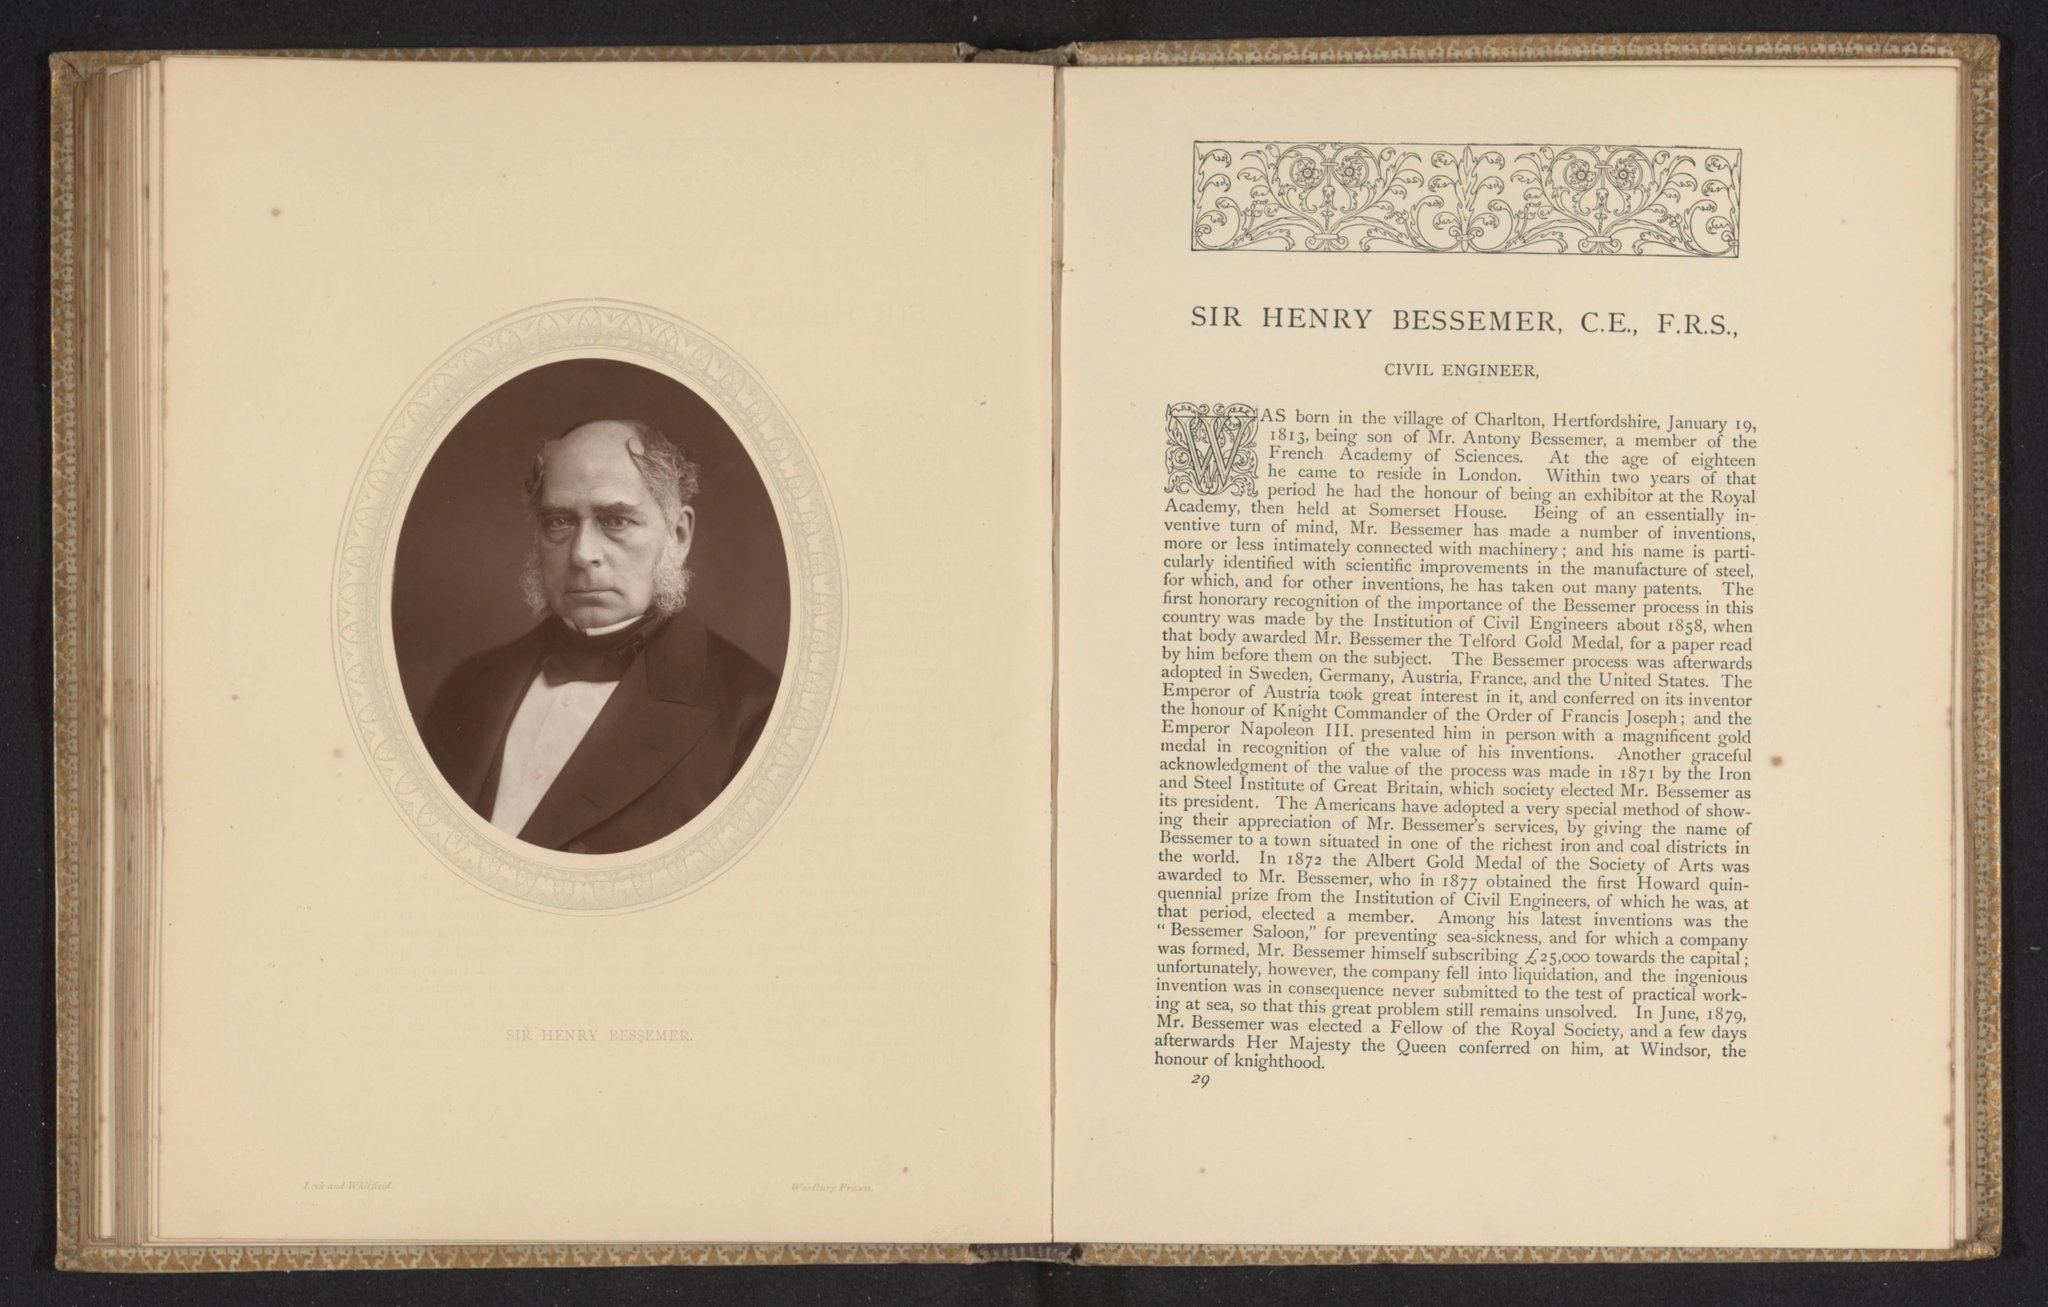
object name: photomechanical print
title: Sir Henry Bessemer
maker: Anonymous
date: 1876-1881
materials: paper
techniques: woodburytype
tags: engineer, engineering, historical persons (portraits and scenes from the life) (+ (full) bust portrait)